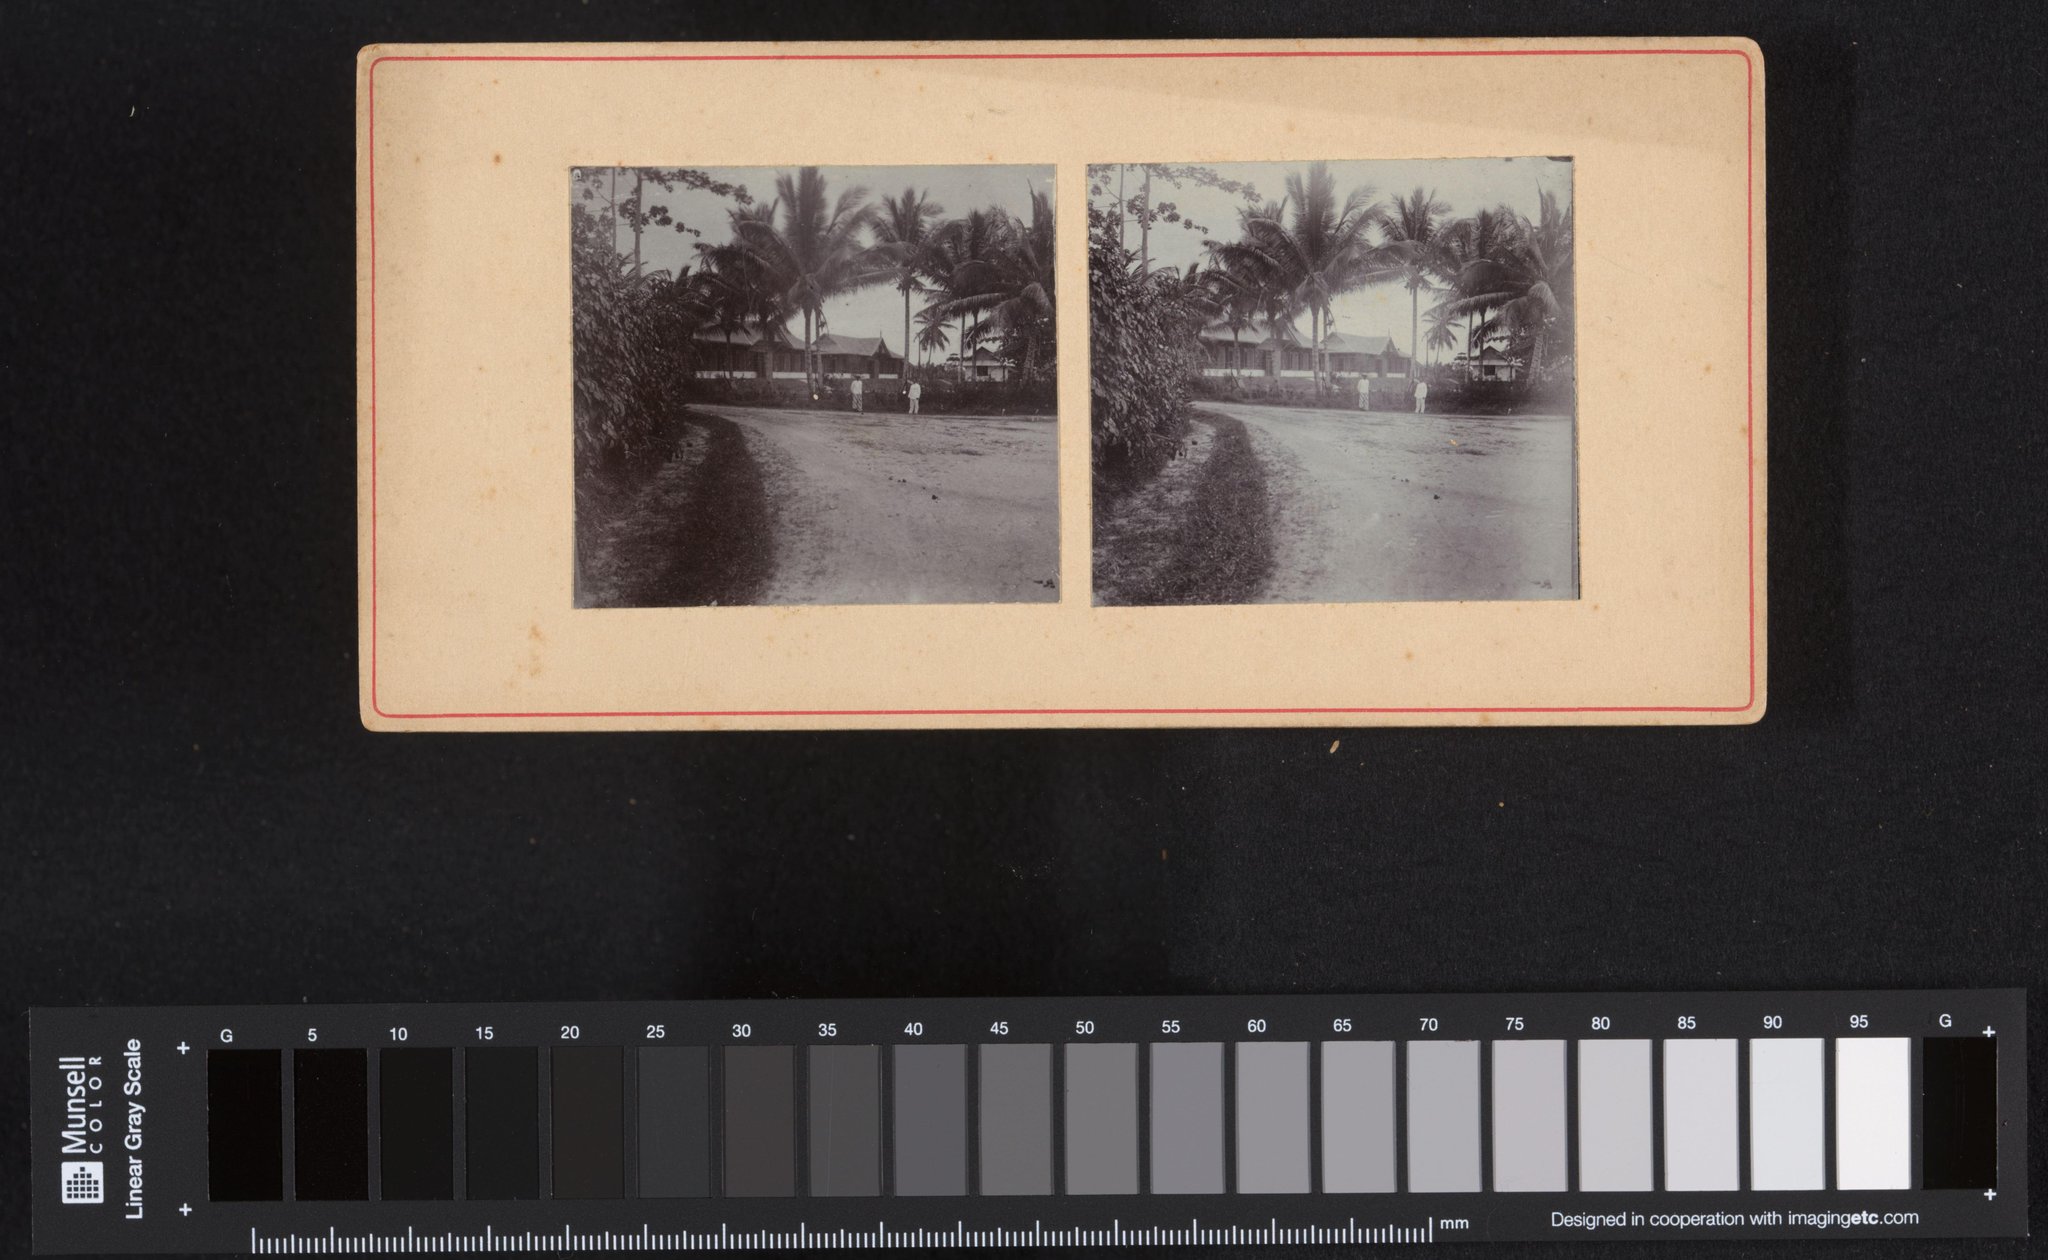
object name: stereograph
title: Weg met palmen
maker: robert julius boers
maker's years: 1867-1932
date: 1900-1922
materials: cardboard, photographic support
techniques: gelatin silver print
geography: bangka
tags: robert julius boers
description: Een weg met enkele gebouwen en palmen, op Banka. Onderdeel van een groep stereofoto's van Robert Julius Boers, chef van het staatsbedrijf de Banka-tinwinning op Banka, uit de periode ca. 1900-1922.